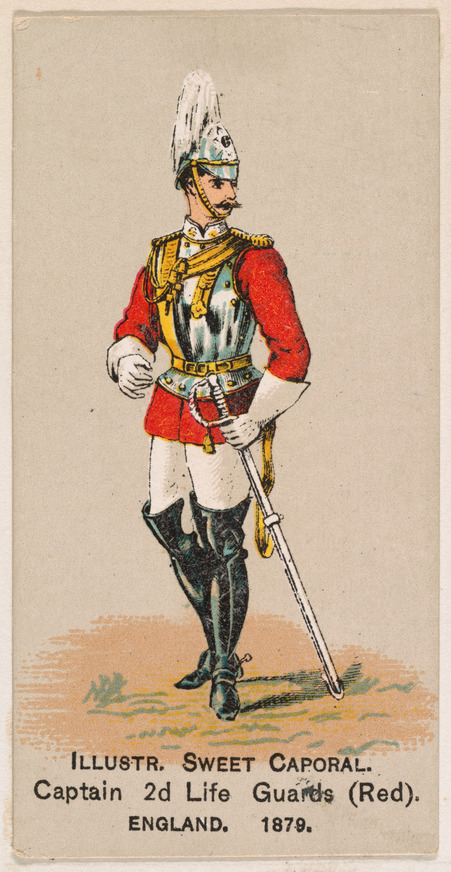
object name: print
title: Captain, 2nd Life Guards (Red), England, 1879, from the Military Series (N224) issued by Kinney Tobacco Company to promote Sweet Caporal Cigarettes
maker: kinney brothers tobacco company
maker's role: publisher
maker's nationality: american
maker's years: 1869-2011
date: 1888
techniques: color lithograph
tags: military,swords,men